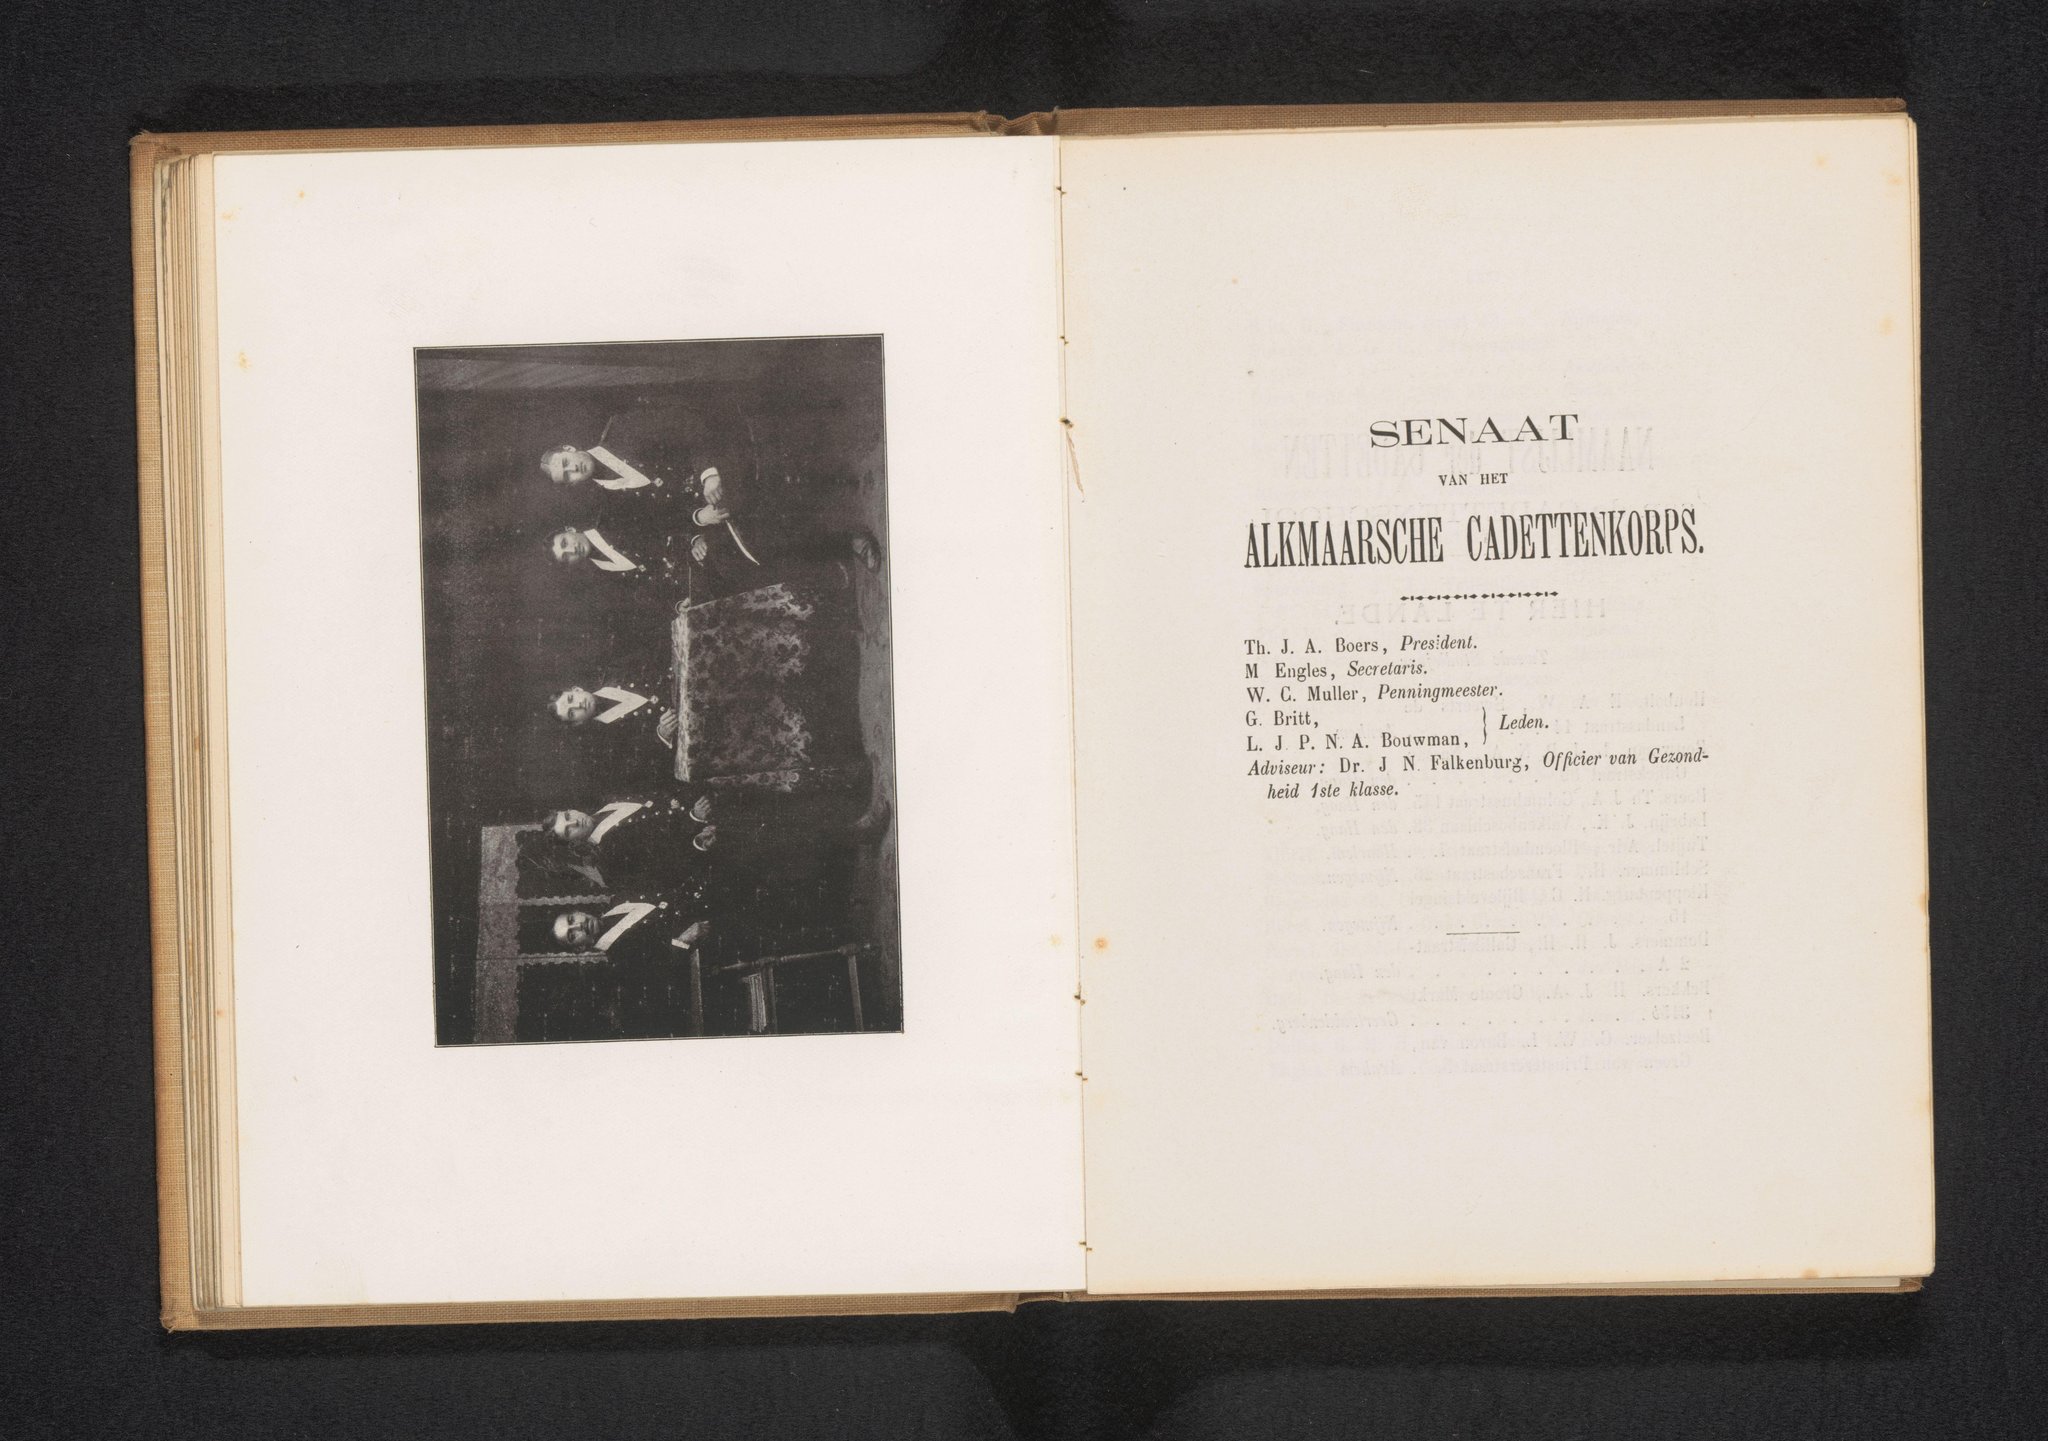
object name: page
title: Groepsportret van de Senaat van het Alkmaarsche Cadettenkorps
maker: Anonymous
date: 1904-1909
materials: paper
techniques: autotype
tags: anonymous historical persons portrayed in a group, in a group-portrait